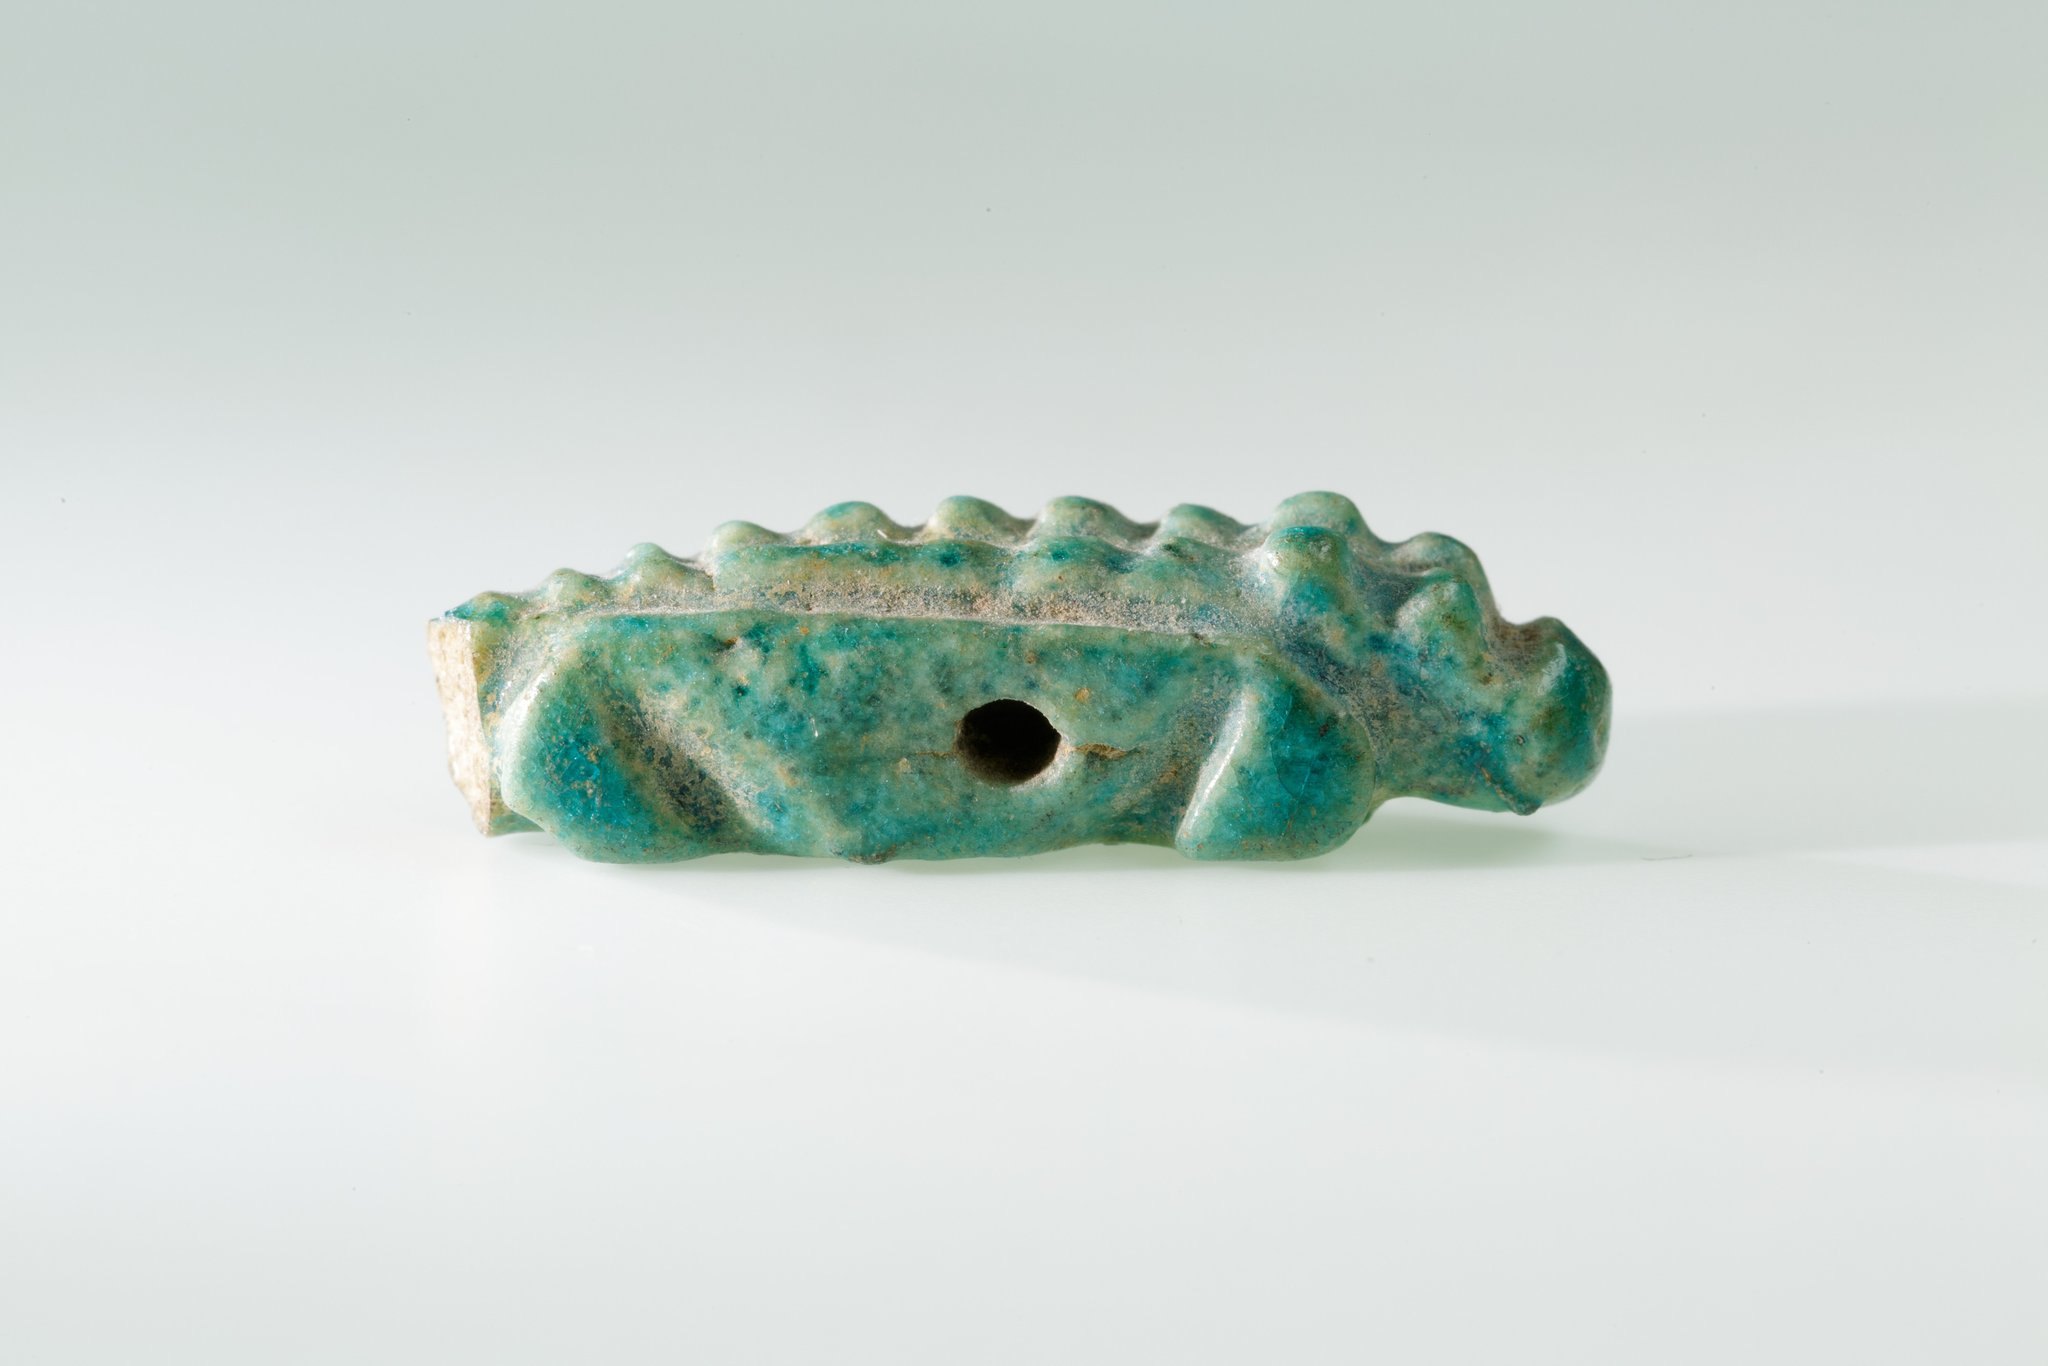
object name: amulet, crocodile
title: Crocodile amulet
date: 1295-1070 BCE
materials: faience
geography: egypt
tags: crocodiles